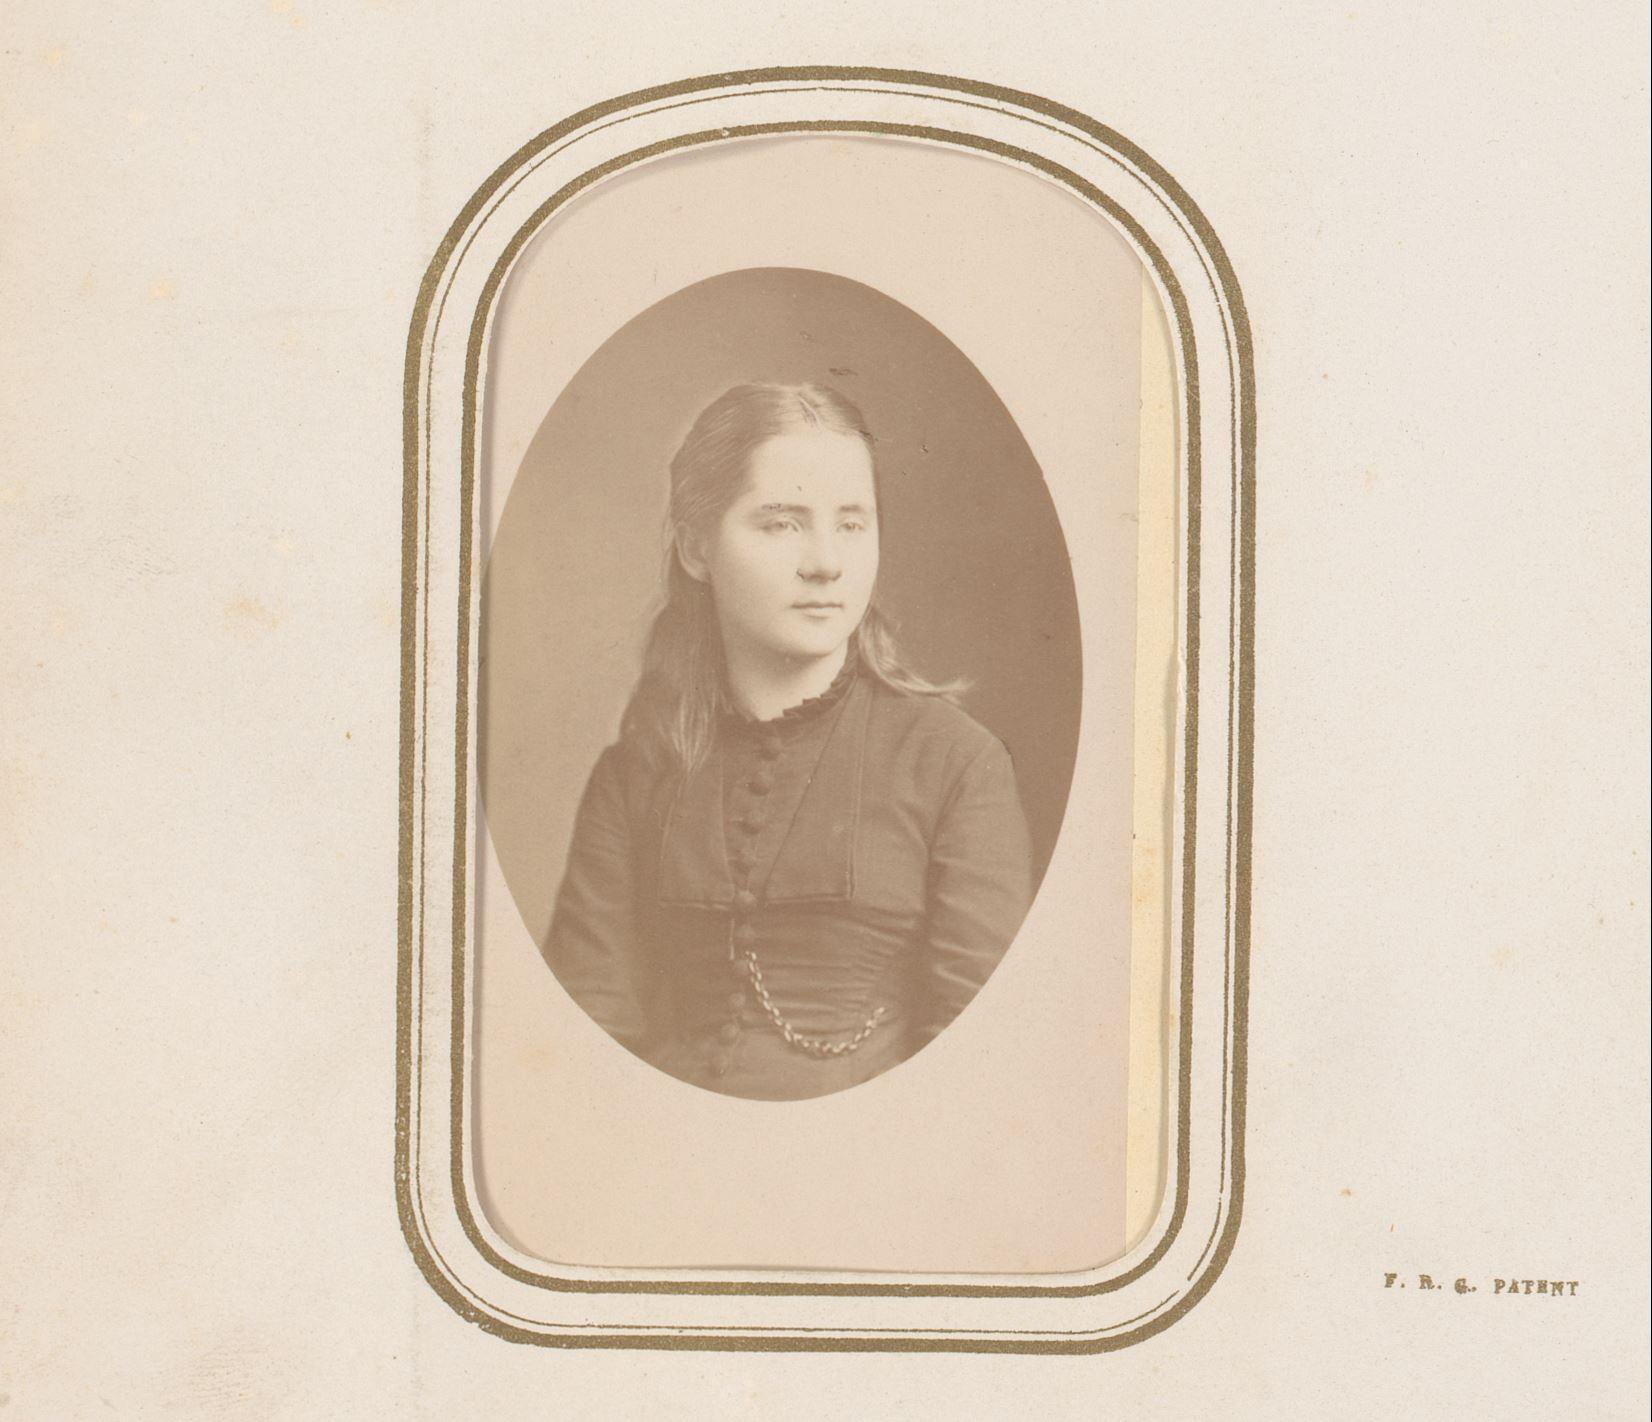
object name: carte de visite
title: Portret van een jonge vrouw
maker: tissier aîné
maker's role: fotograaf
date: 1850-1890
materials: cardboard, photographic support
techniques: albumen print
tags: adolescent, young woman, maiden, historical persons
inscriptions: inscription: ‘Peinture et Photographie/ Tissier Ainé/ 31, Rue le Grand, 32/ Pavillon de Hanovre/ Paris’